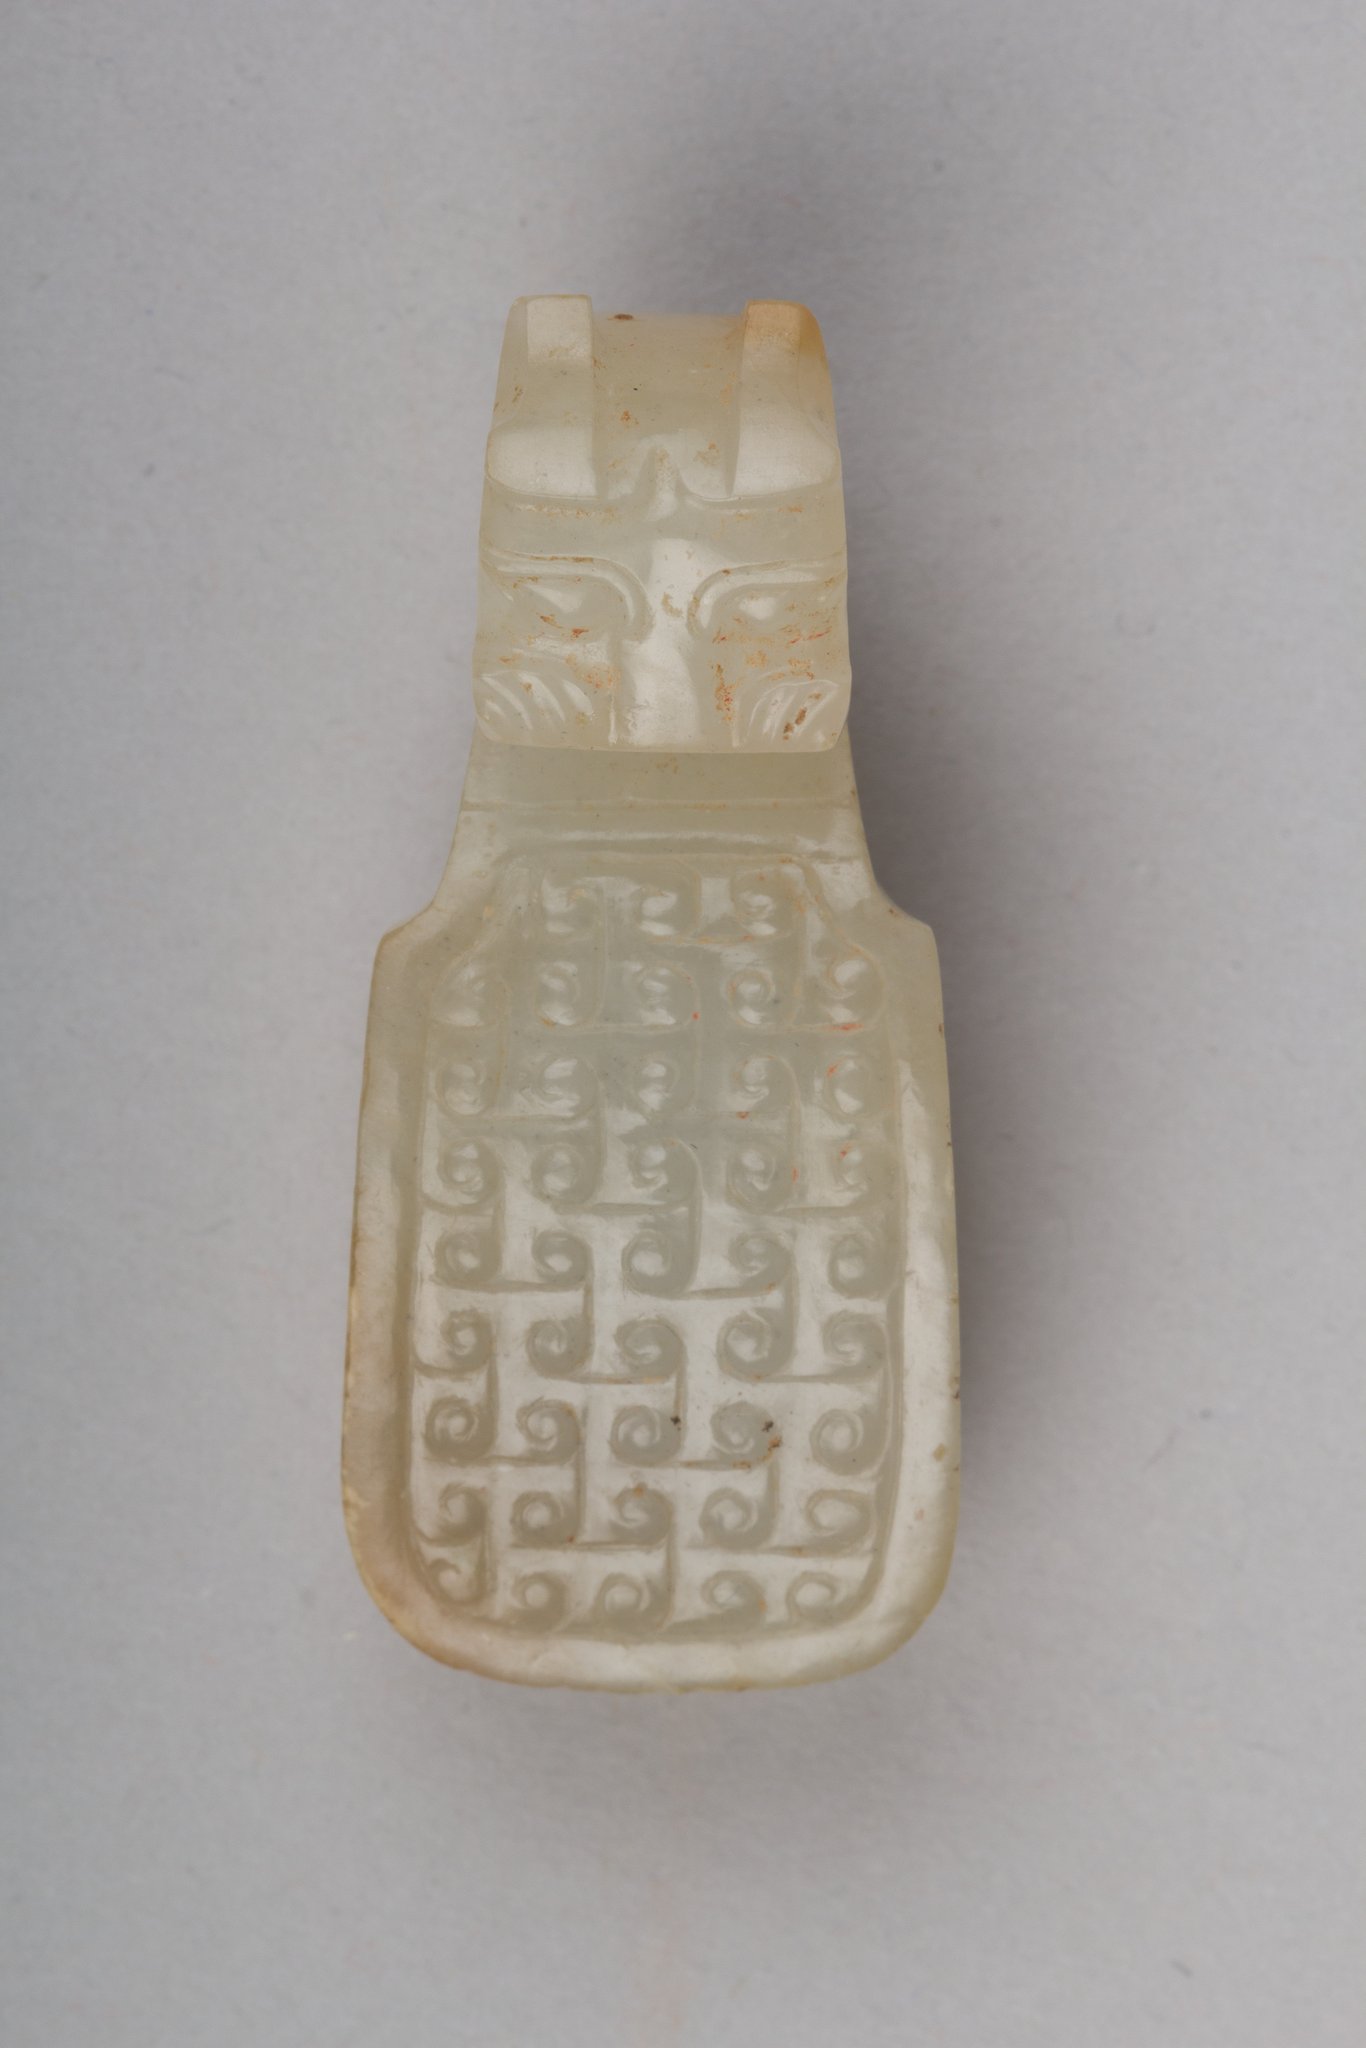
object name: belt hook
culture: chinese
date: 500-201 BCE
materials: jade